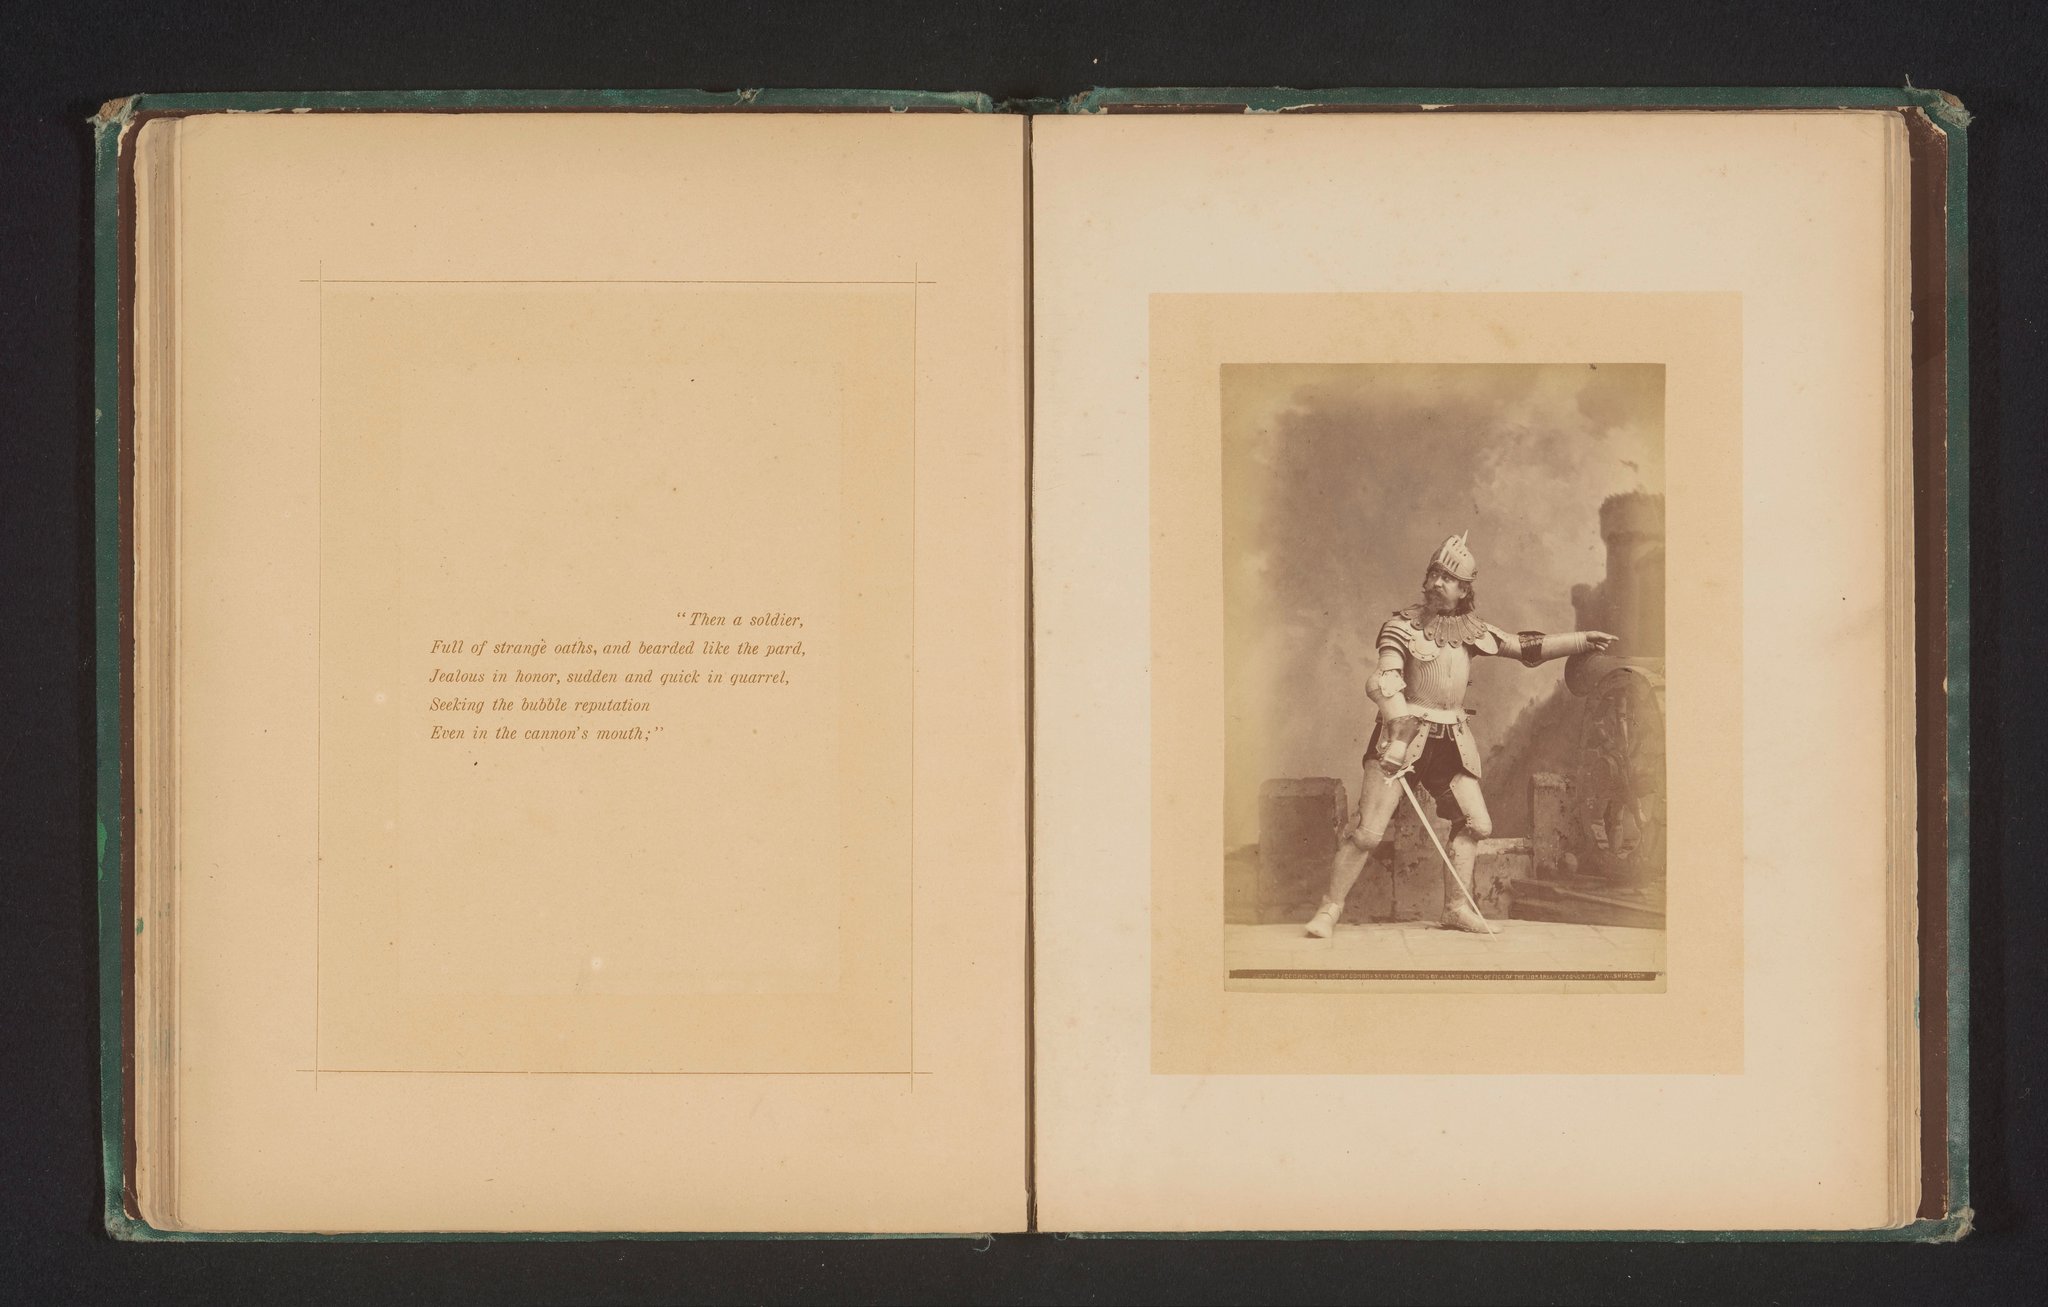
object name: page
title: De soldaat uit The seven ages of man - As you like it van William Shakespeare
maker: james m. landy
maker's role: fotograaf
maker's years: 1838-1897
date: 1872-1877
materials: photographic support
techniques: albumen print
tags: theatre, theatrical performance, adult man, historical persons, the soldier; the soldier's life